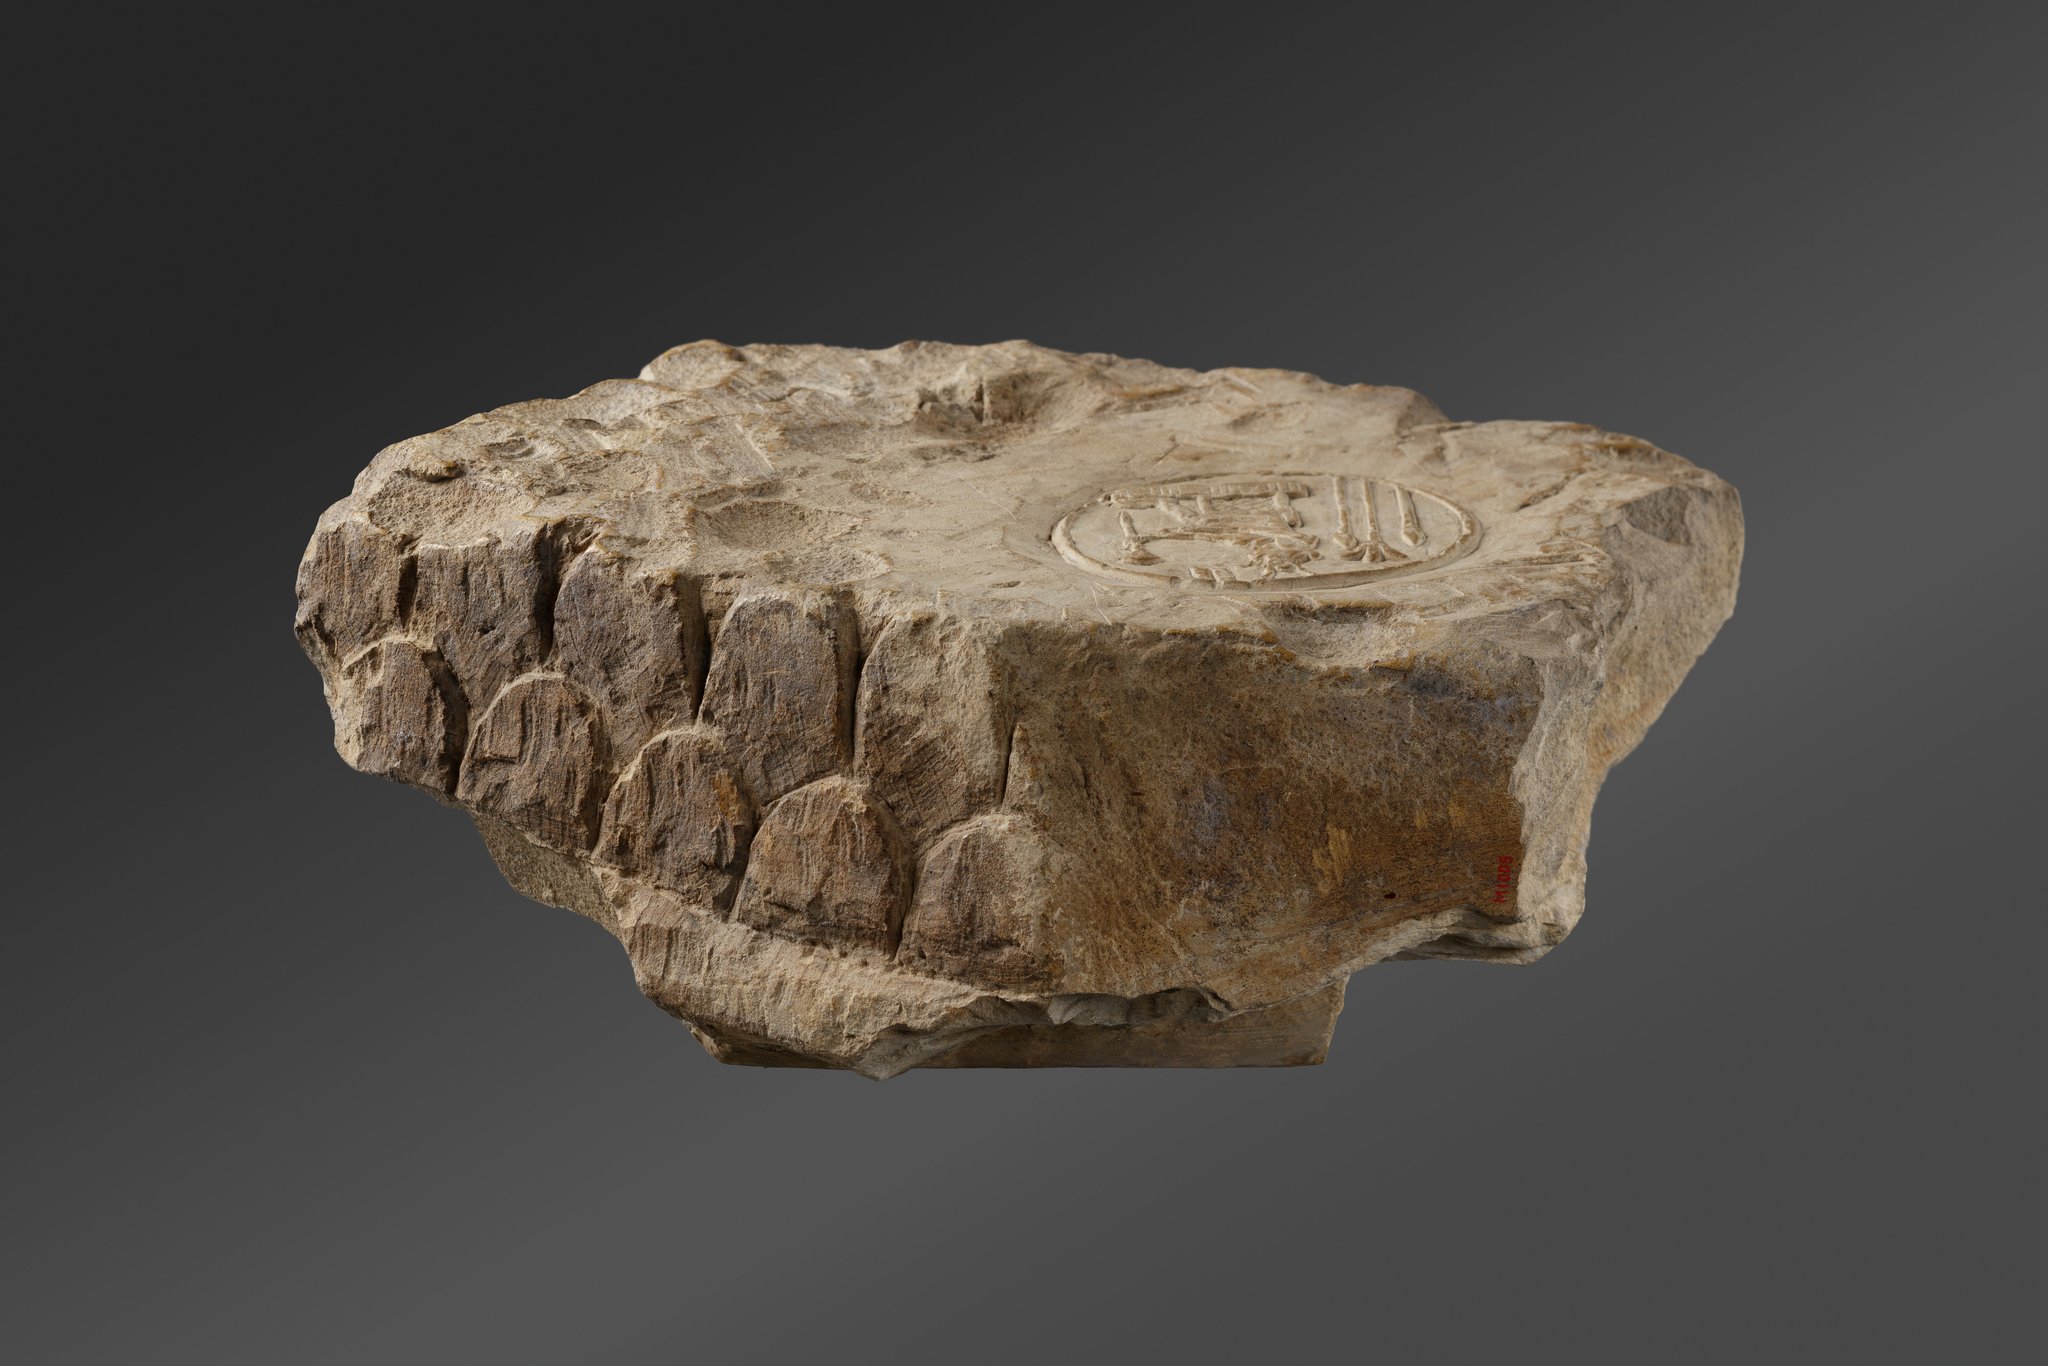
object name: relief fragment, trial piece, lion deity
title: Possible trial piece depicting a lion-headed deity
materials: stone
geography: egypt